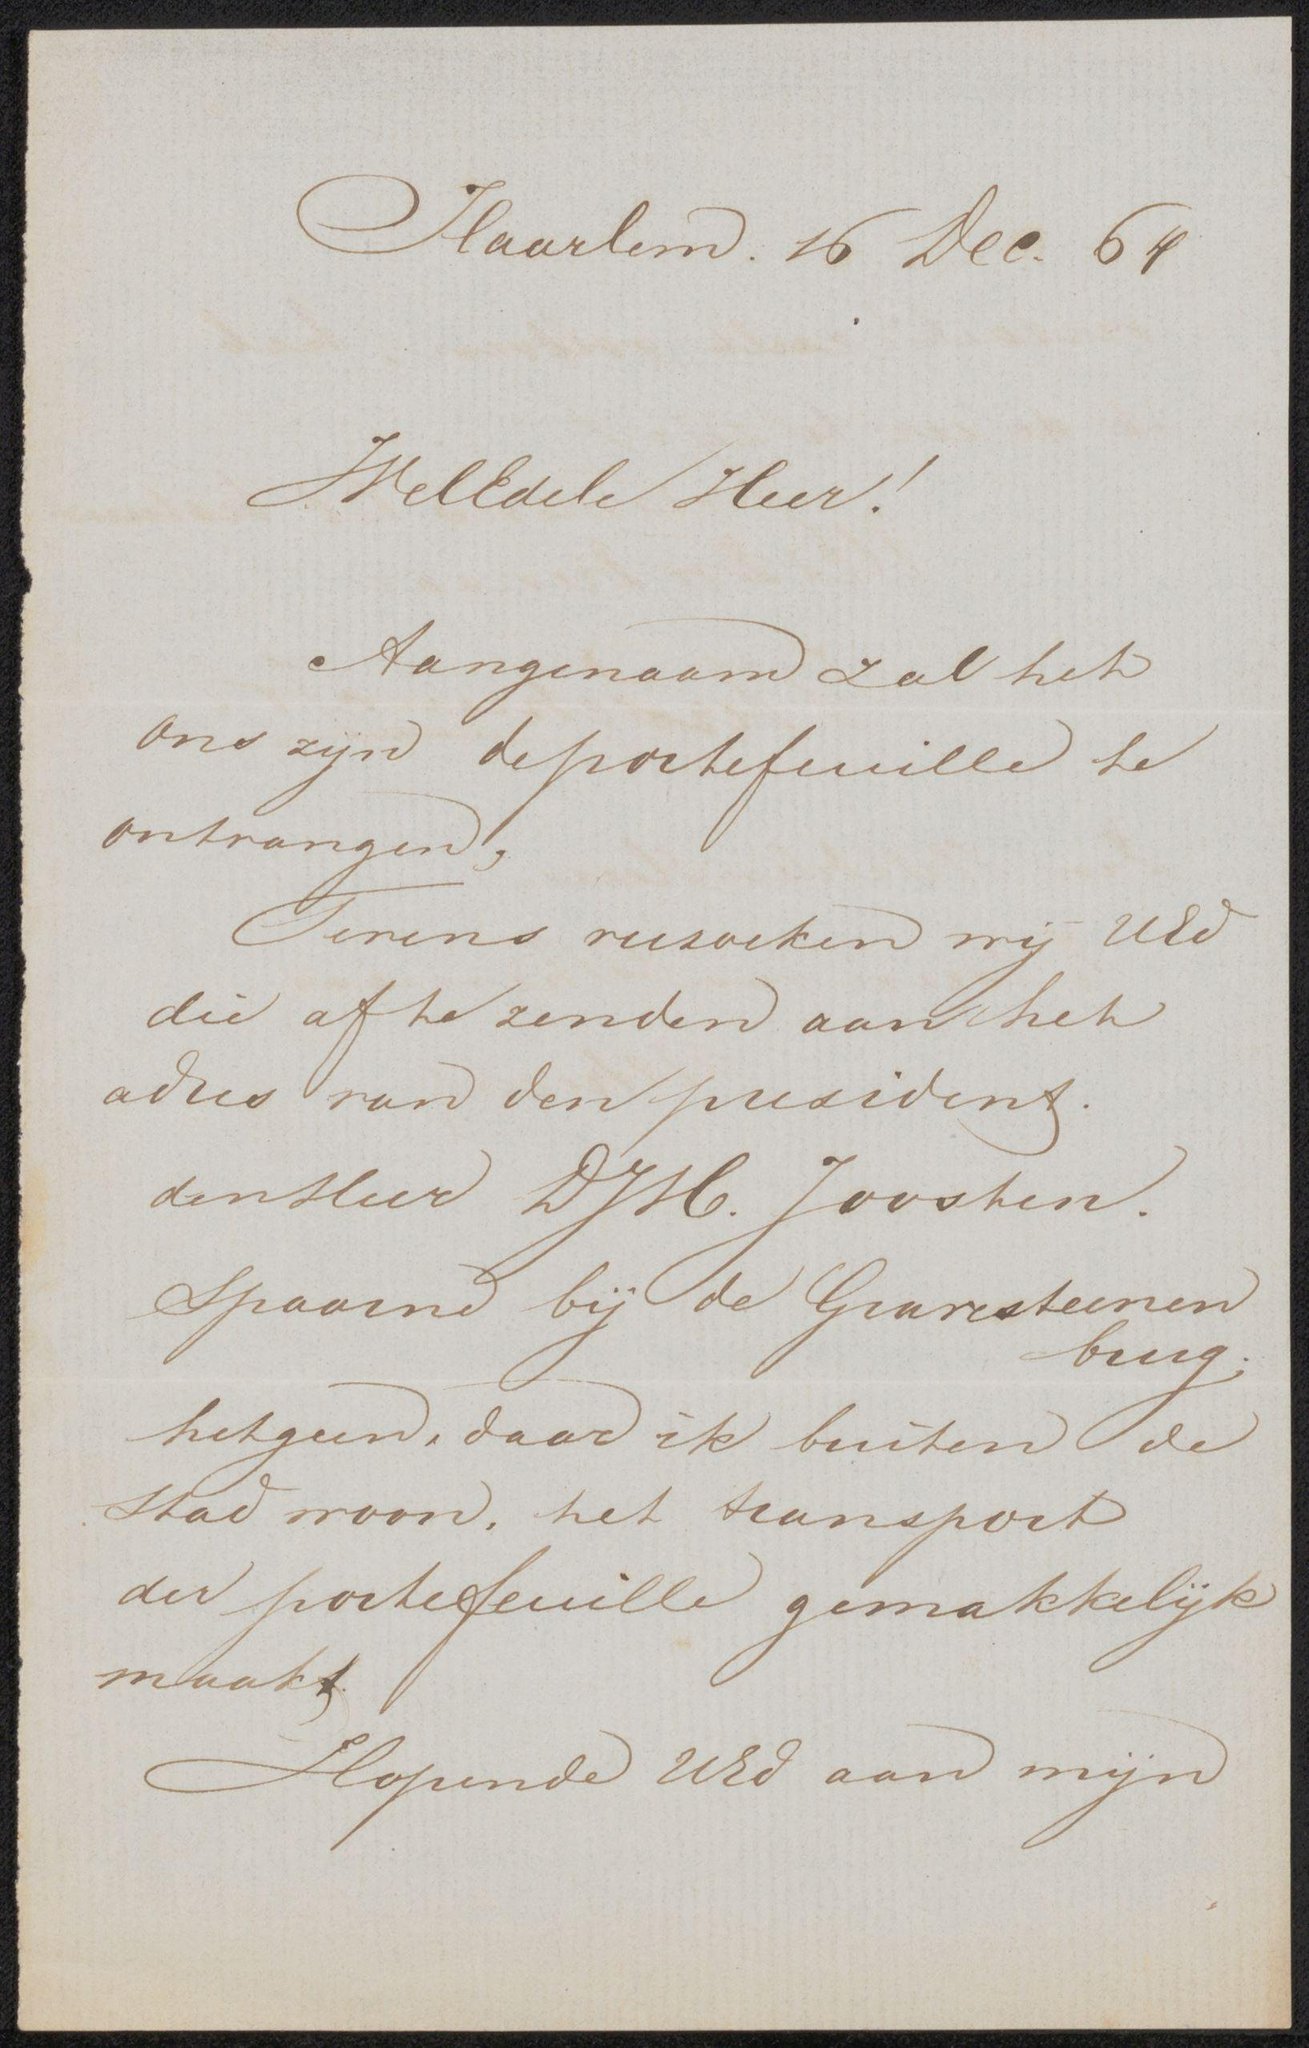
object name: letter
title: Brief aan Pieter Verloren van Themaat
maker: wouter verschuur (1841-1936)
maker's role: draughtsman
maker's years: 1841-1936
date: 1864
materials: ink, paper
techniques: pen, writing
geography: haarlem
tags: utrecht, pieter verloren van themaat, haarlem, draughtsman, dirk jan hendrik joosten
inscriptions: collector's mark: ‘RPK’